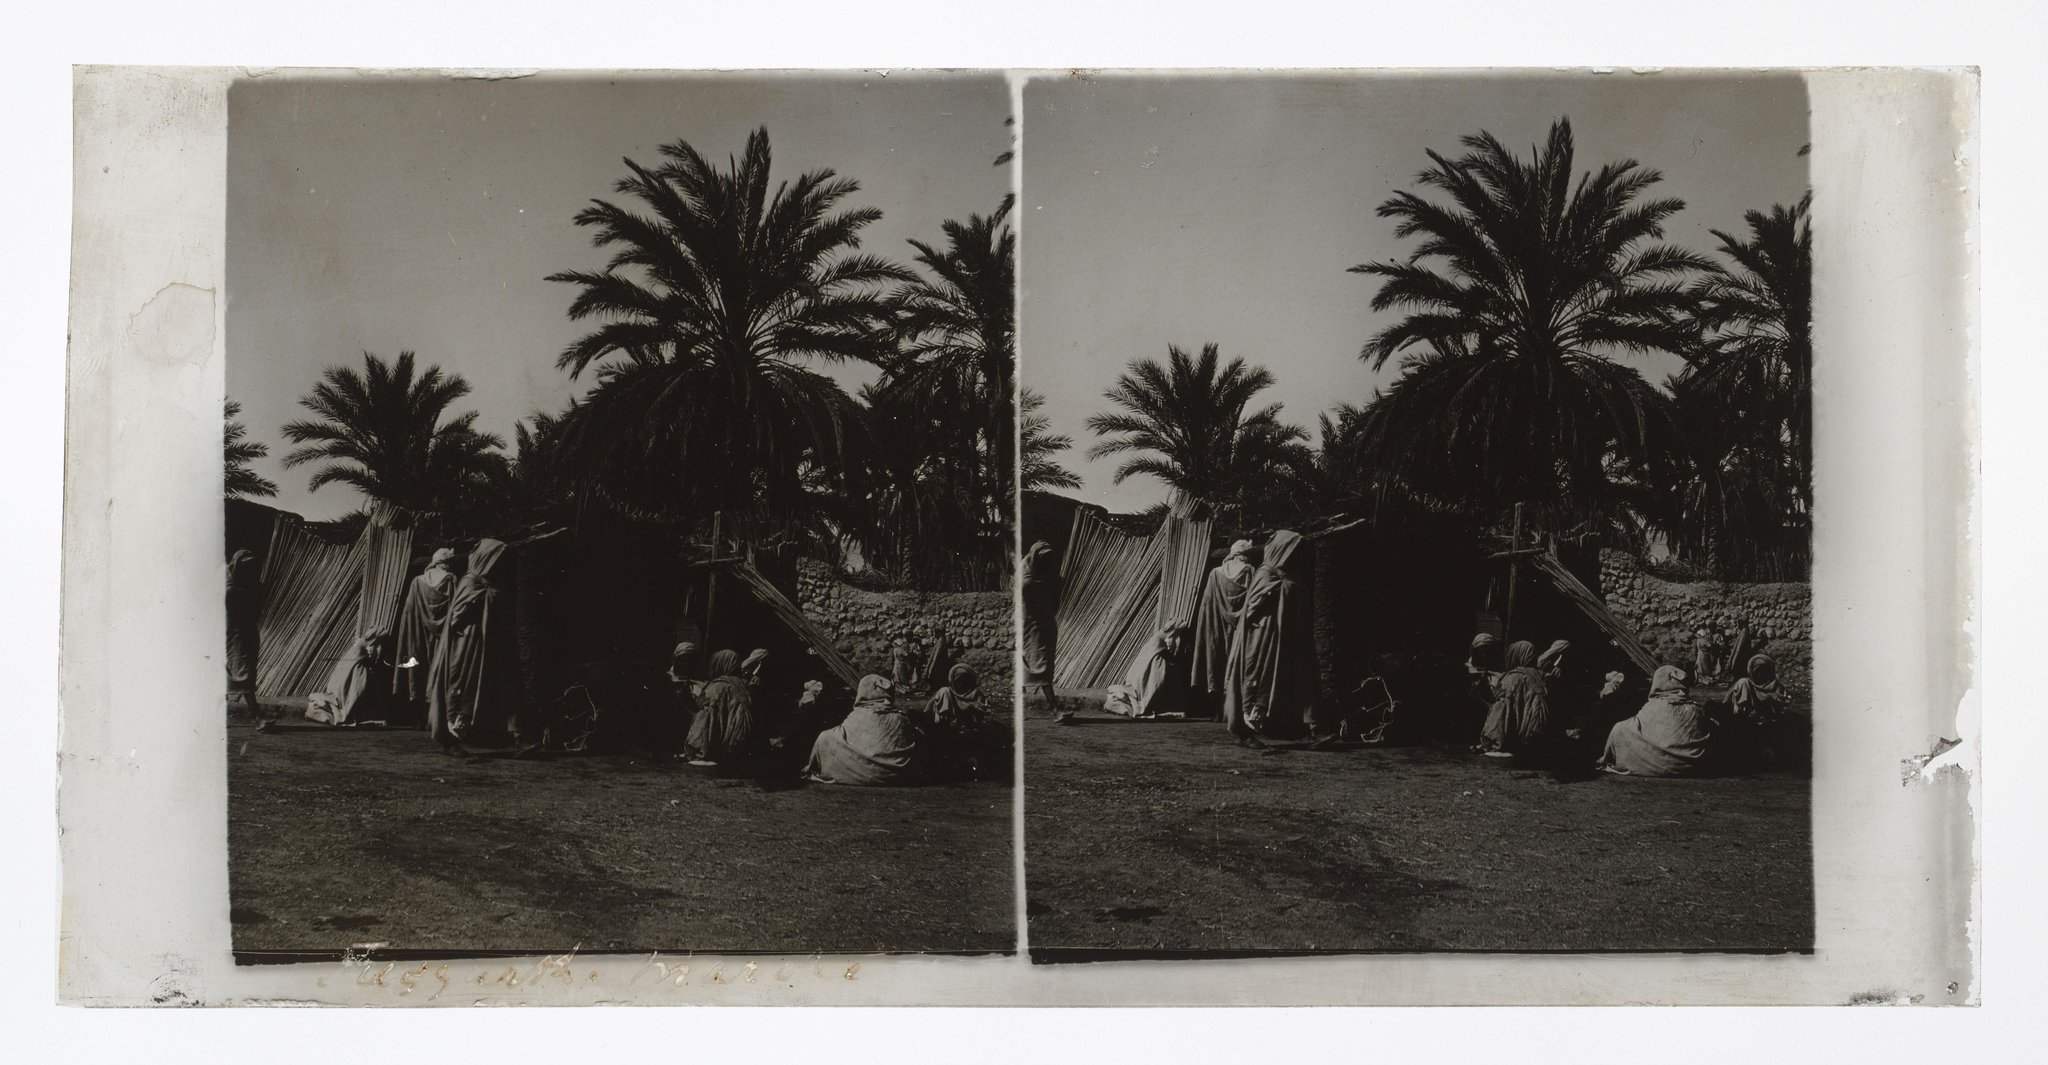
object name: stereoscopic photograph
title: Groep mensen op een markt, mogelijk in Algiers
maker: Anonymous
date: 1890-1910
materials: glass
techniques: slide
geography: algiers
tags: village, market, trees: palm-tree